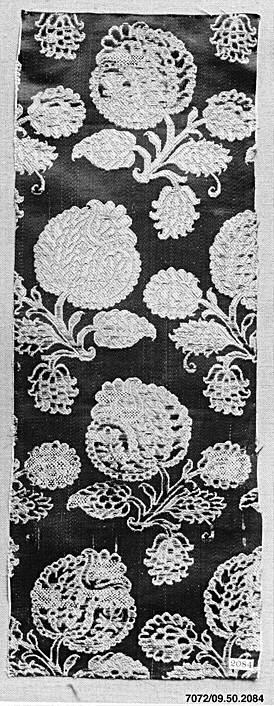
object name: textile fragment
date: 1801-1900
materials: silk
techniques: compound weave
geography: turkey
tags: flowers